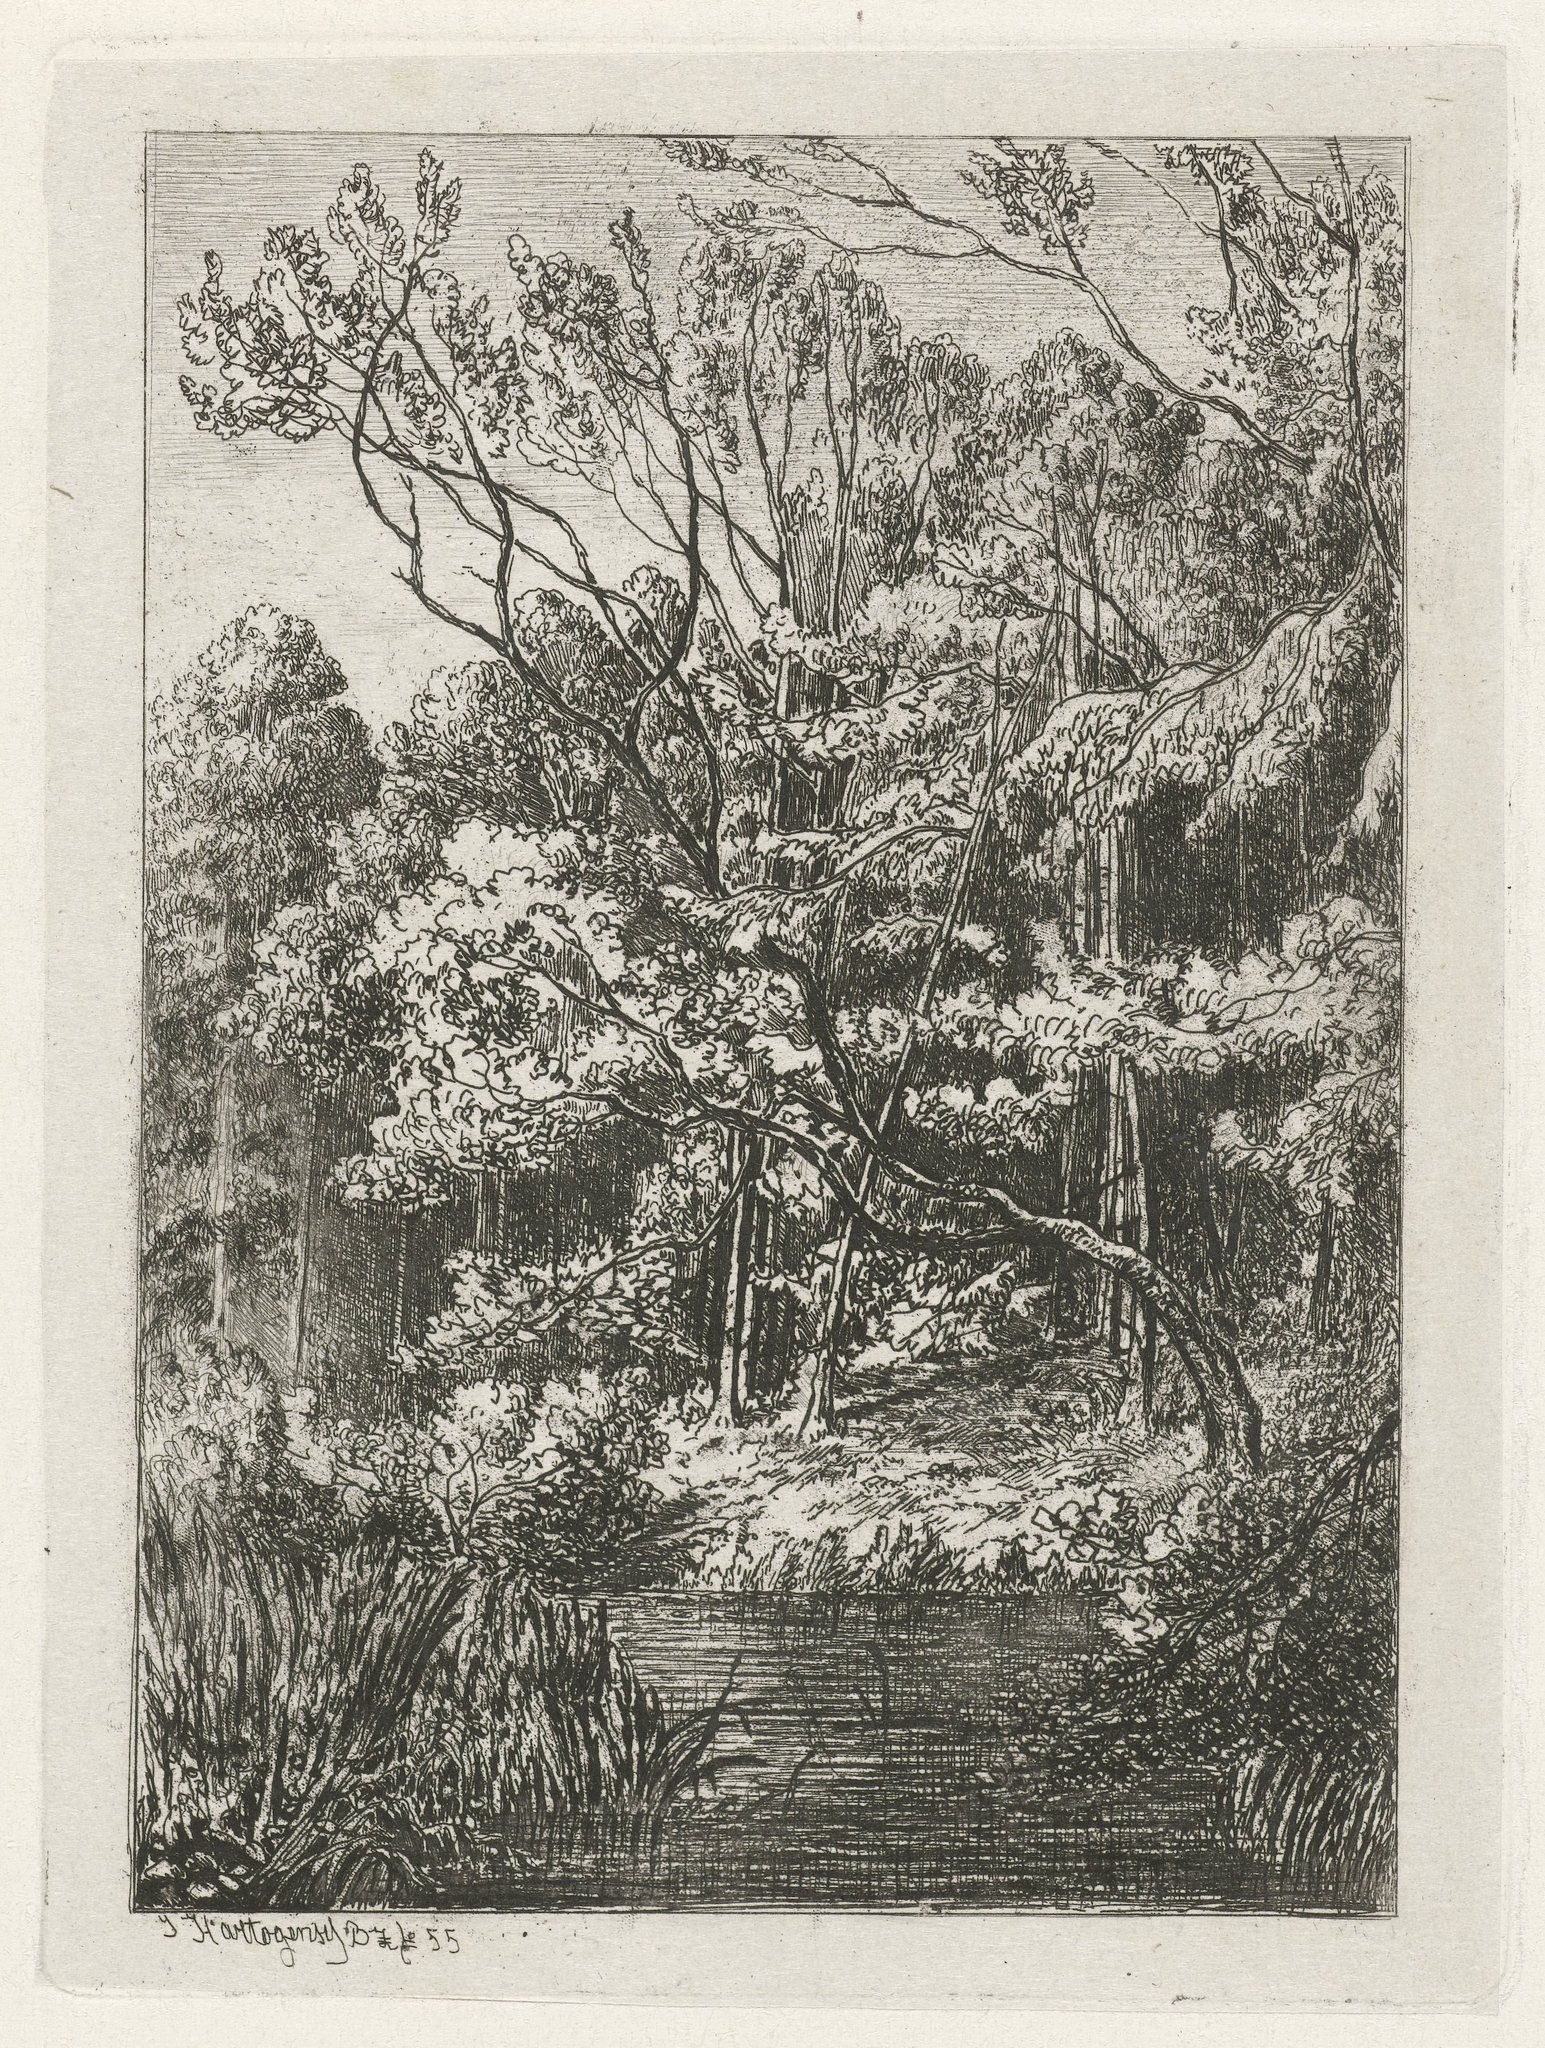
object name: print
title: Bosgezicht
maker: joseph hartogensis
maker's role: painter, print maker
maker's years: 1822-1865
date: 1855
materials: paper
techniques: drypoint, etching, roulette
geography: the hague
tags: water course, forest, wood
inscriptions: collector's mark: Lugt 2228